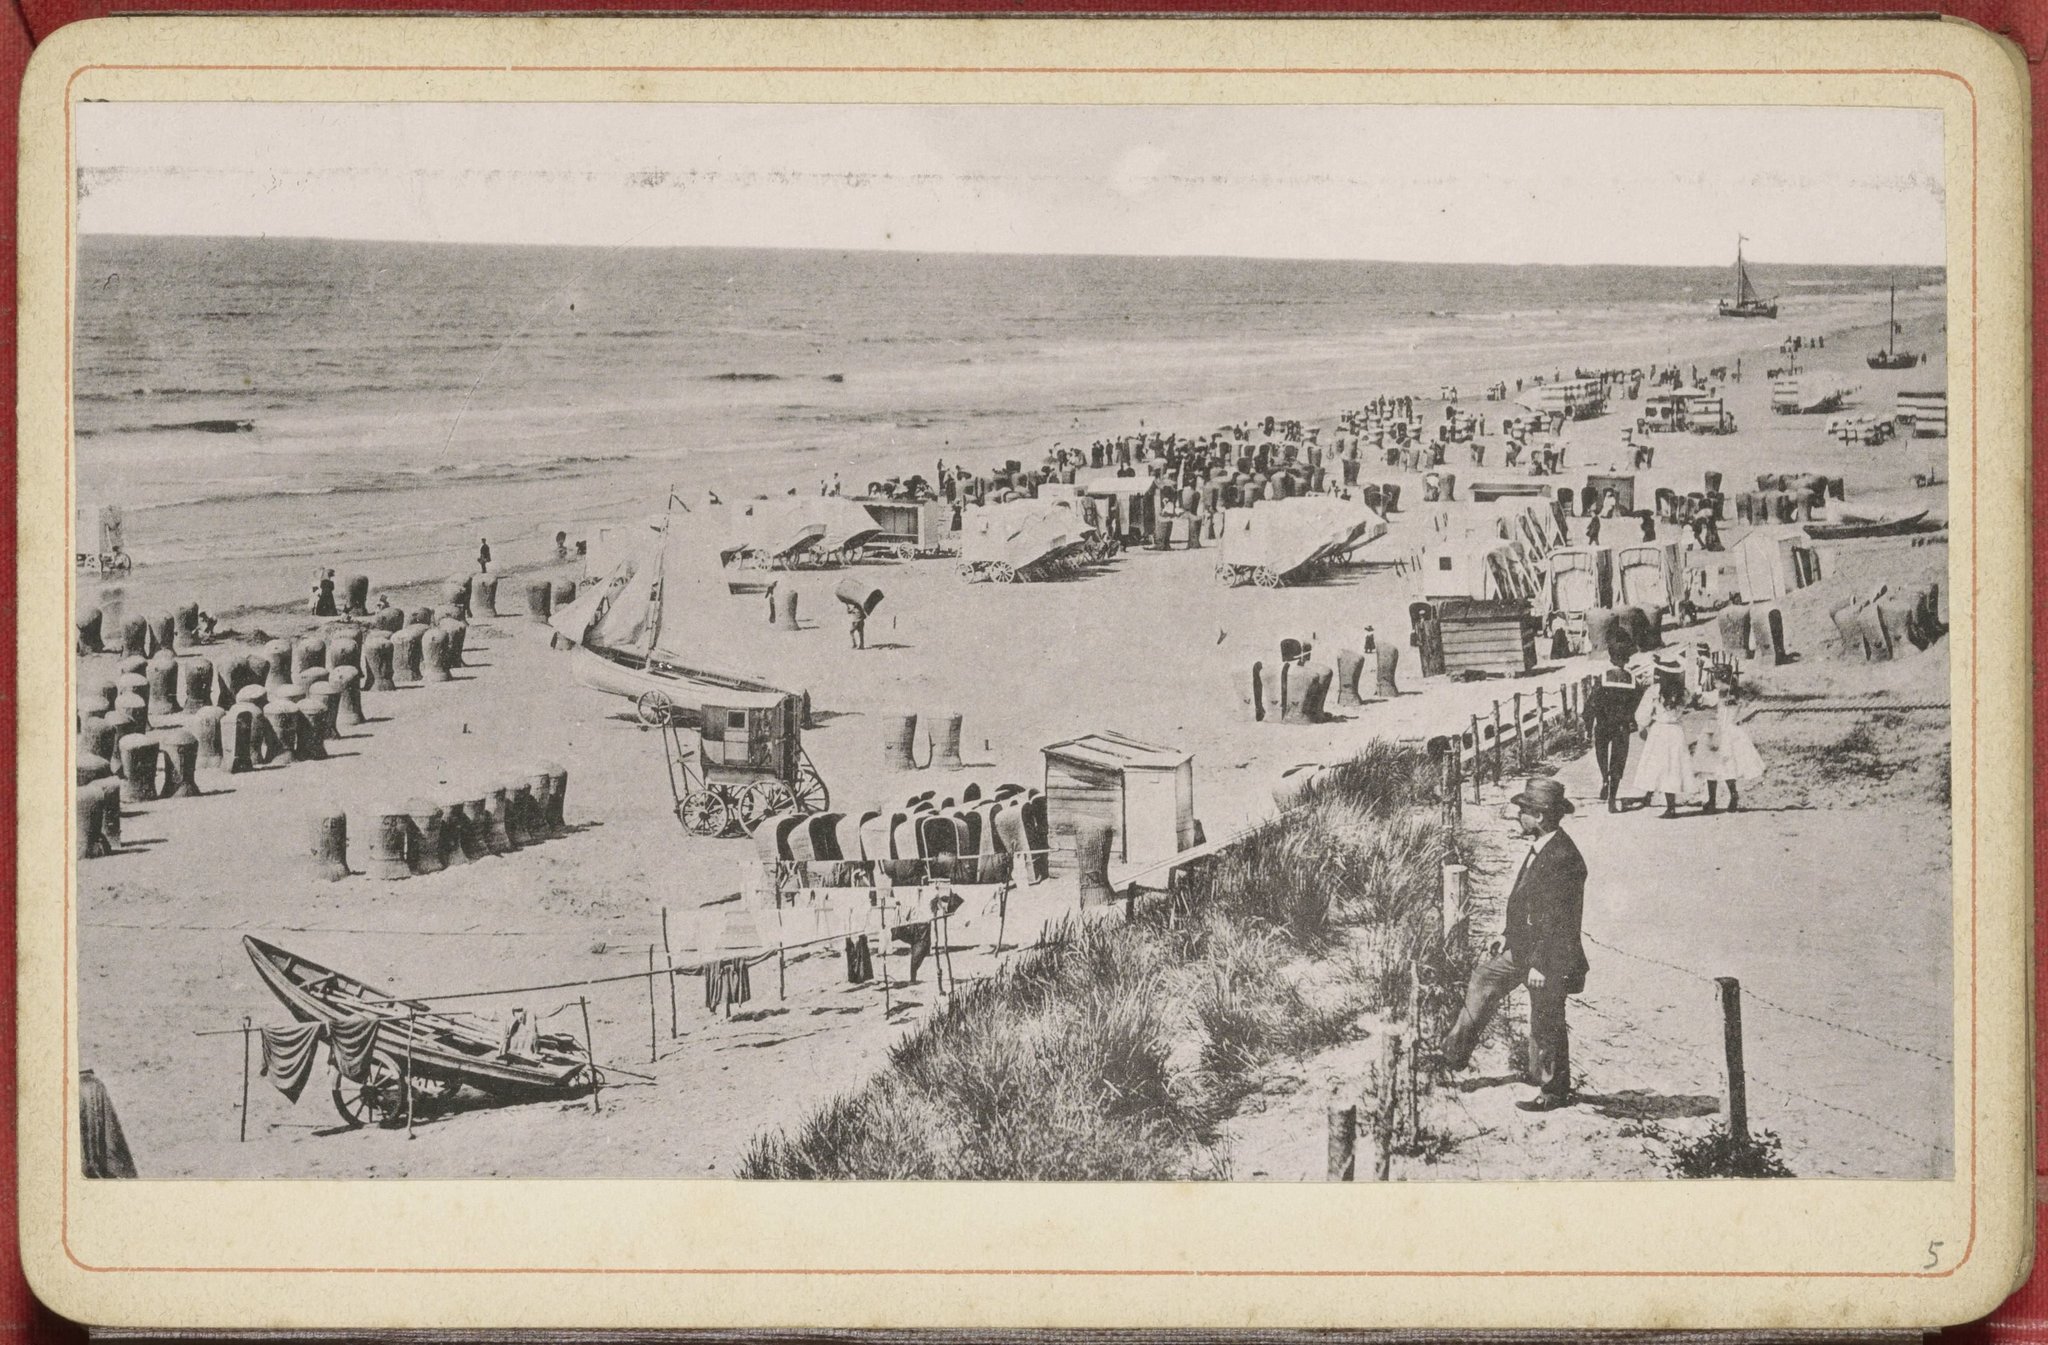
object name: photomechanical print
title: Strandgezicht in Zandvoort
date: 1890-1900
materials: paper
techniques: photograph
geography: zandvoort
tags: beach (as place of recreation), chair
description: Onderdeel van Leporelloalbum met opnames van Zandvoort.